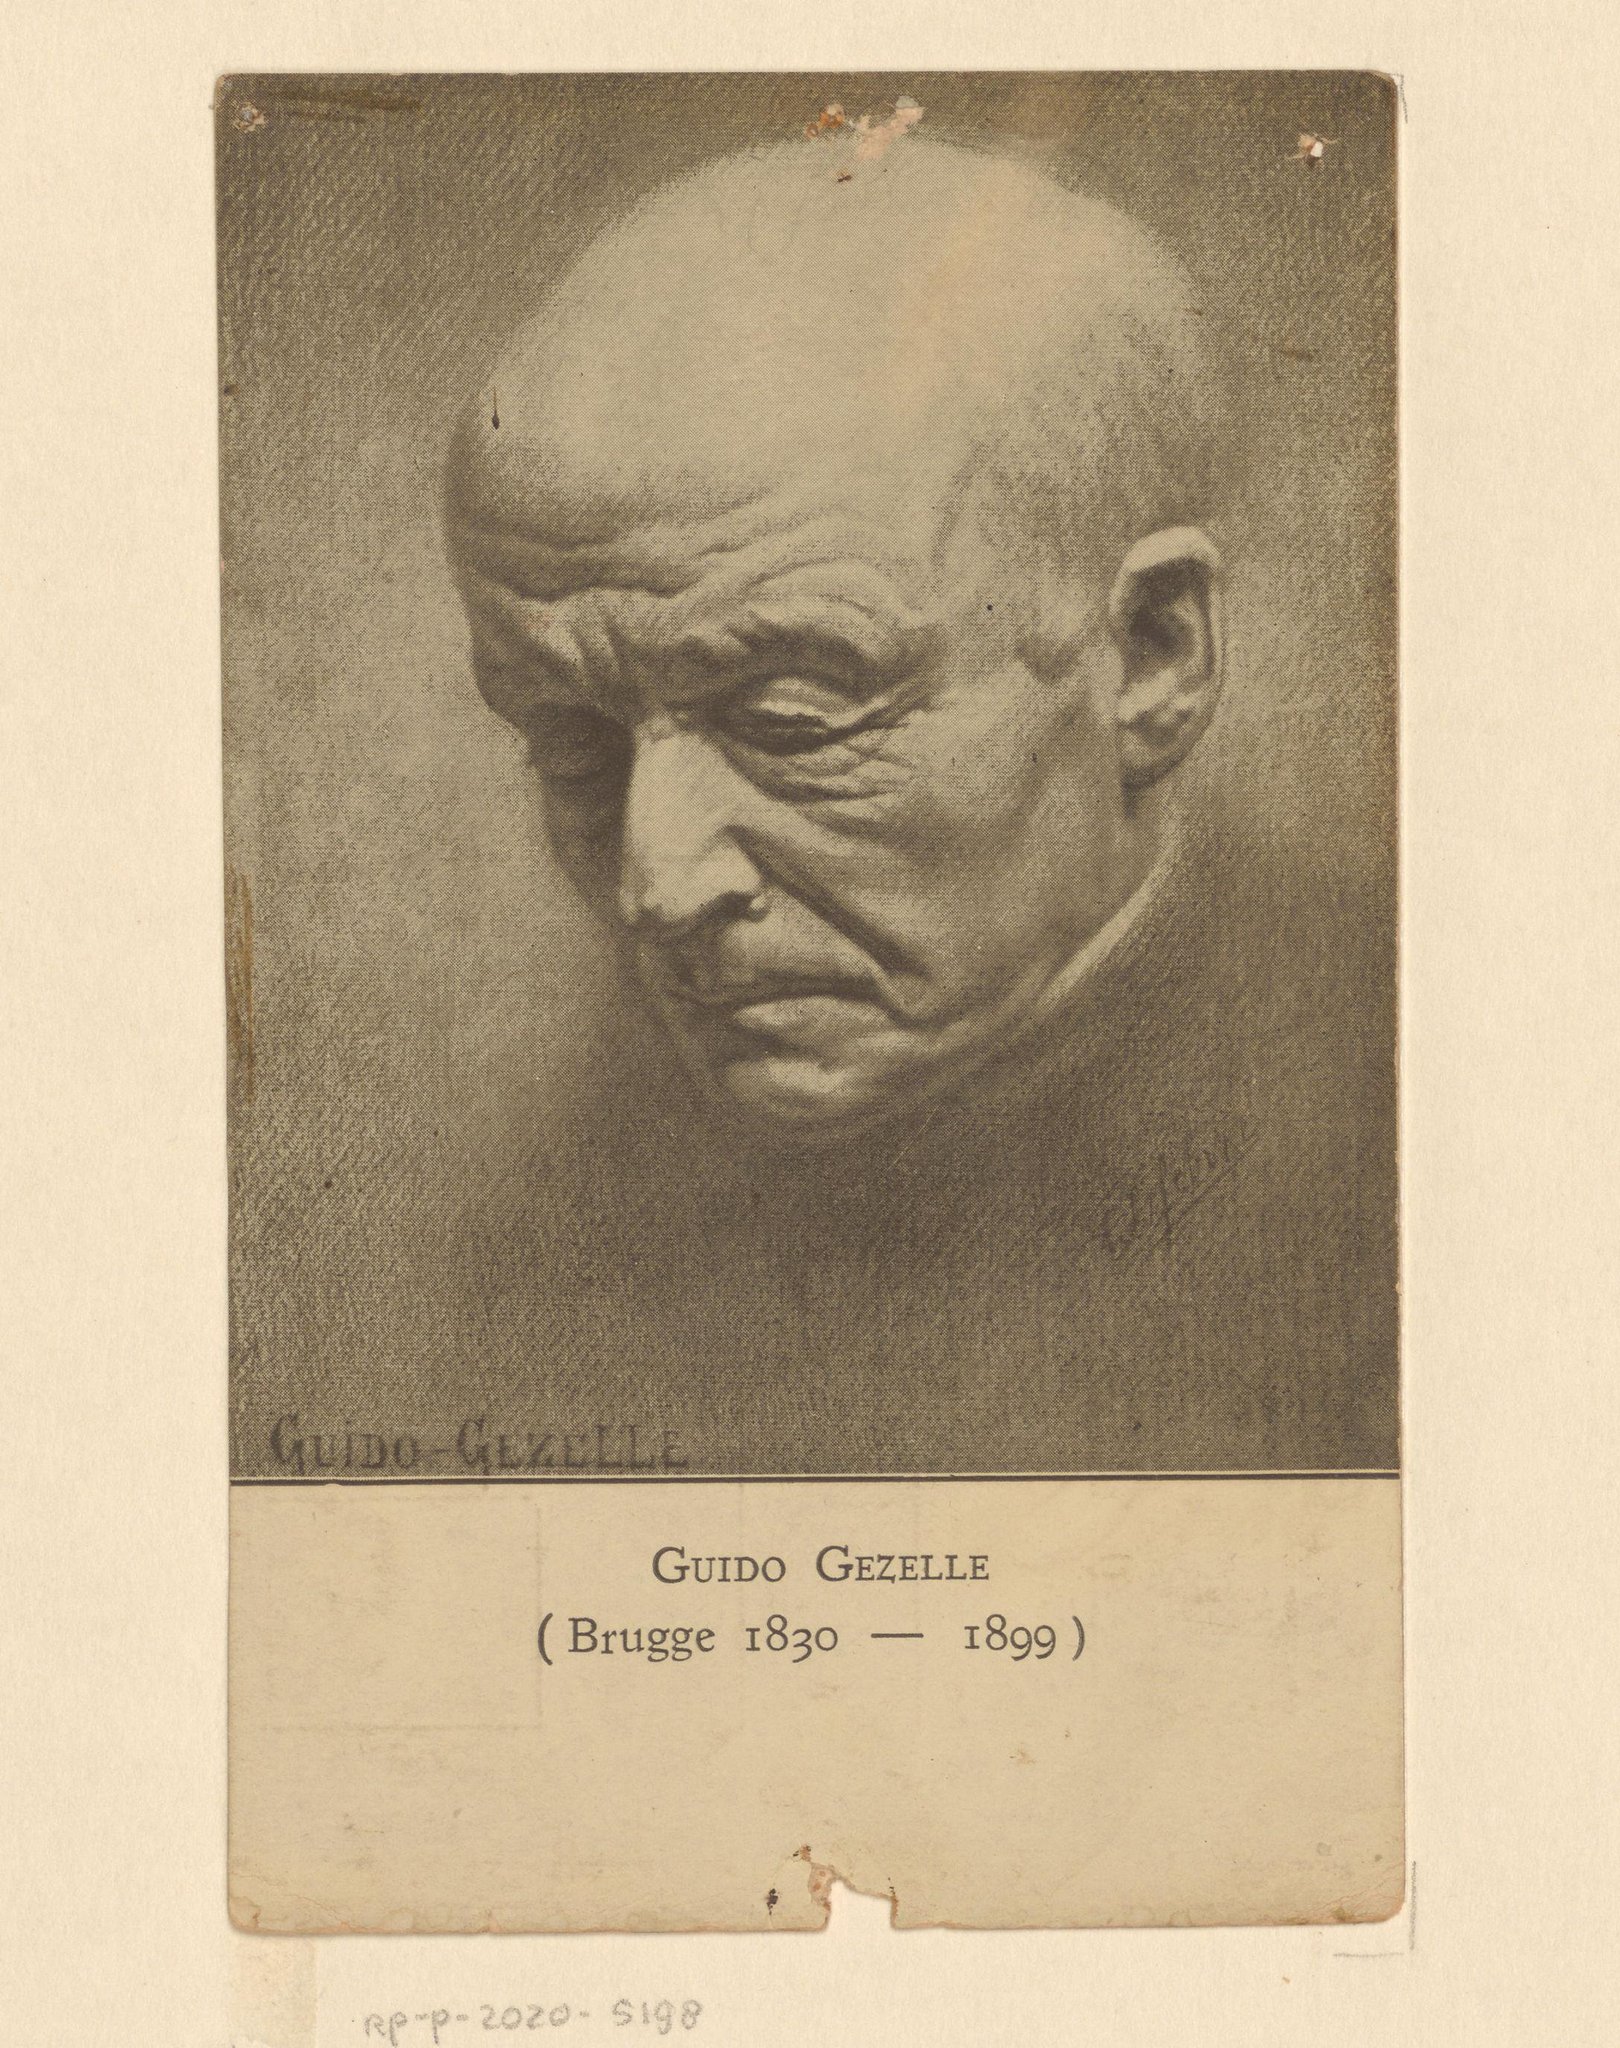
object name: ansichtkaart, prentbriefkaart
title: Portret van Guido Gezelle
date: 1923-1930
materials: cardboard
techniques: autotype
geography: antwerp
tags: bruges, priest, guido gezelle, historical persons, writer, poet, author